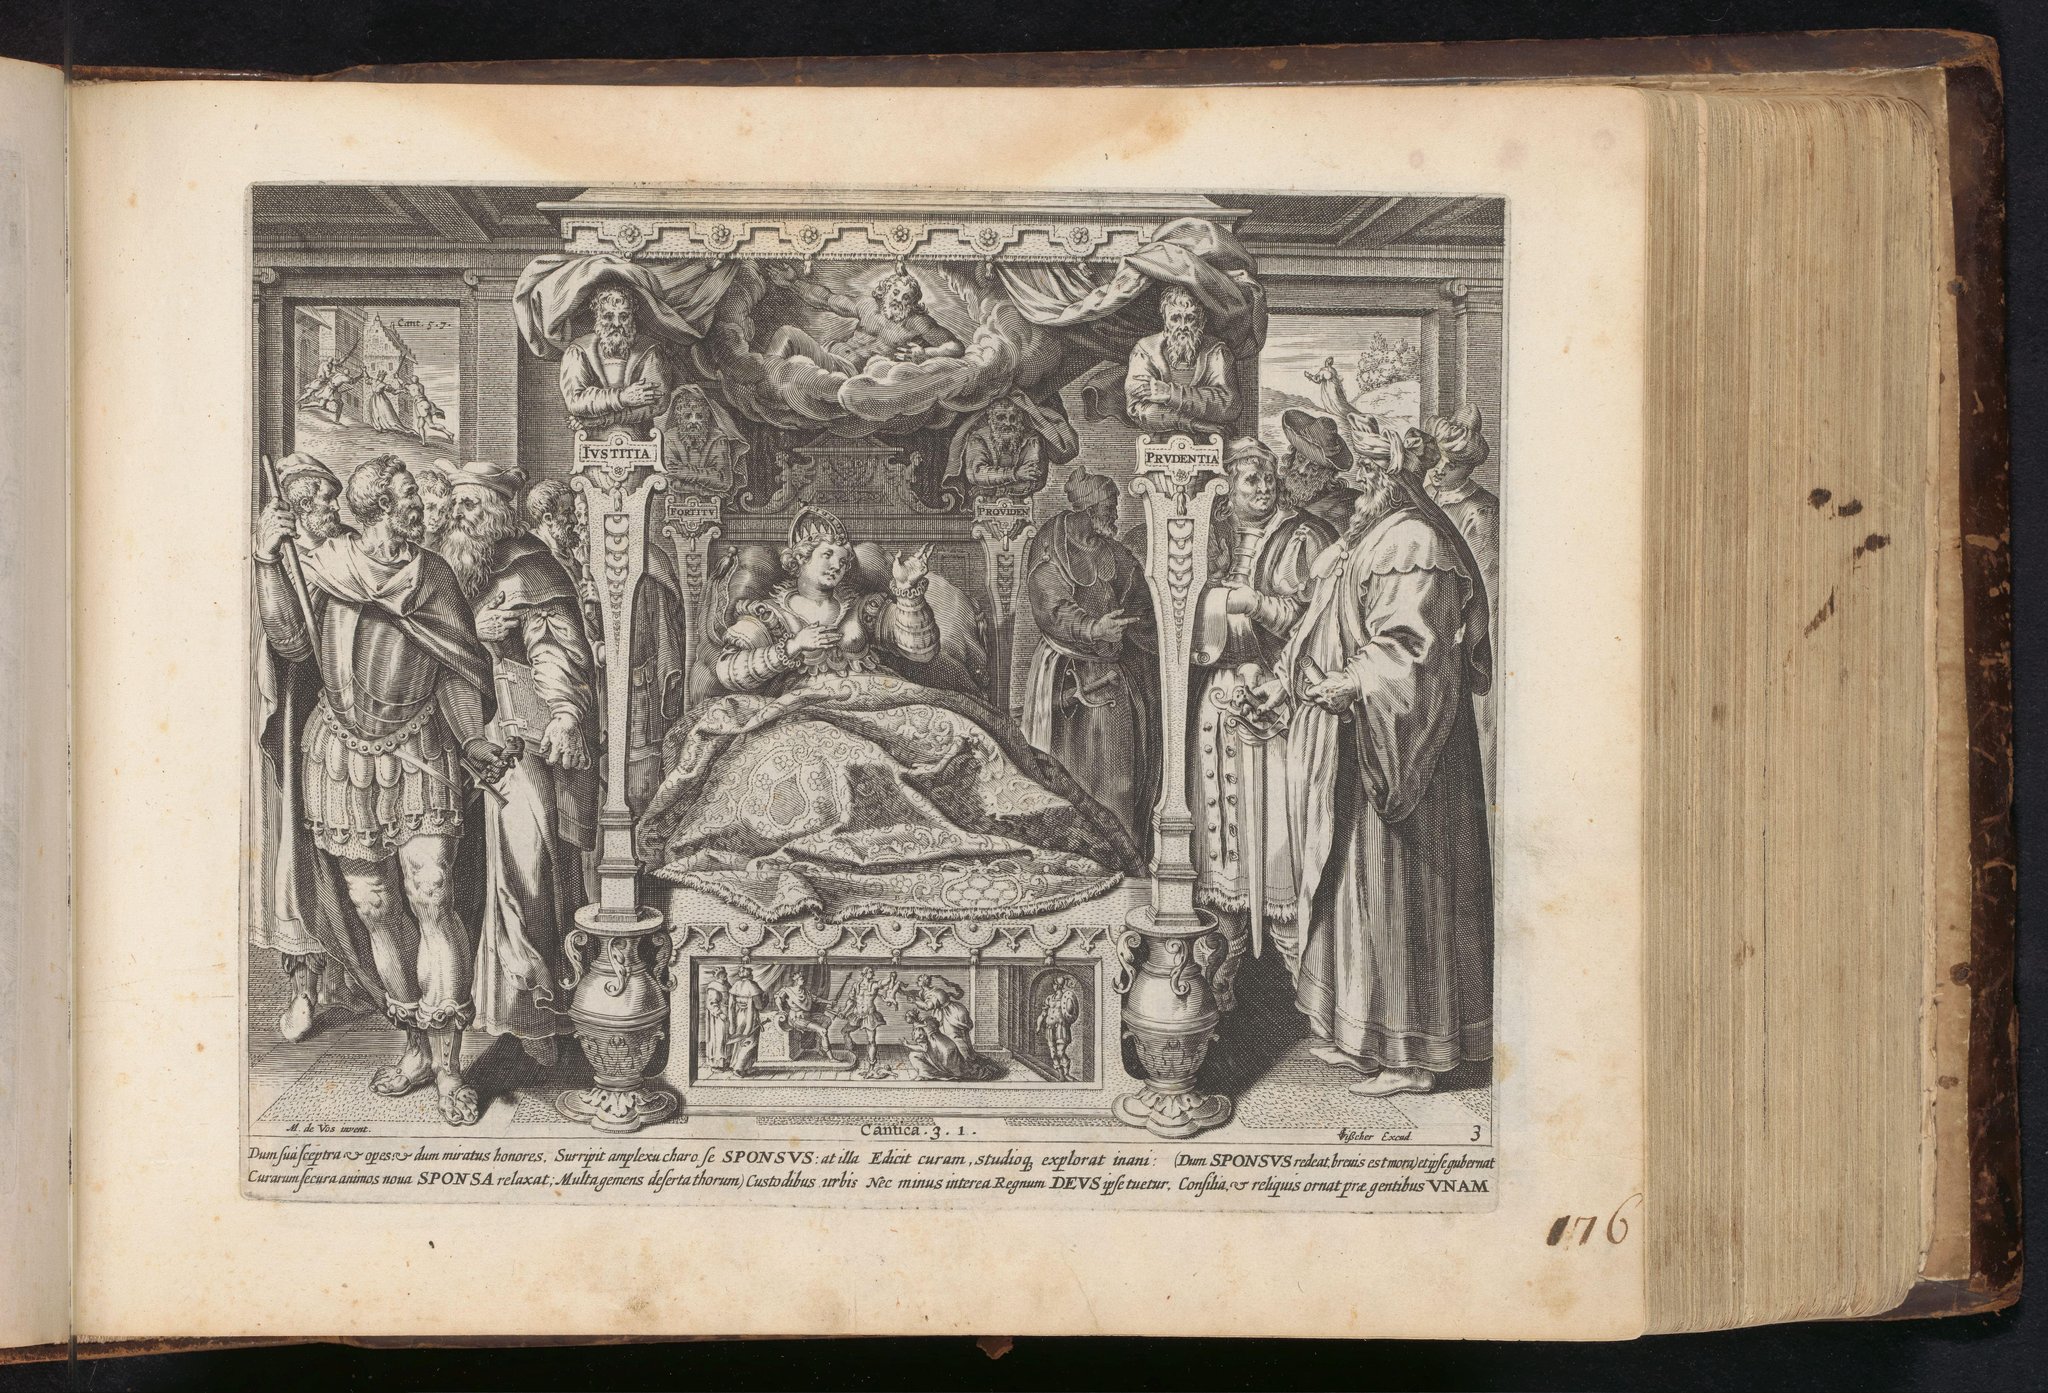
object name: print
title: Canticum Canticorum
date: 1643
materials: paper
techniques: engraving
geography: amsterdam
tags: fortitude, 'fortitudo' ~ one of the four cardinal virtues, 'ecclesia' as bride of christ (the lamb), 'ecclesia sponsa dei', 'sponsus-sponsa', song of solomon, song of songs (with book chapter:verse) (+ christ bearded), the judgement of solomon (1 kings 3:16-28), justice, 'justitia'; 'giustitia divina' (ripa) ~ one of the four cardinal virtues, prudence, 'prudentia'; 'prudenza' (ripa) ~ one of the four cardinal virtues, caryatids ~ architecture, bed with tester, forethought, deliberation; 'previdenza', 'providenza' (ripa), groups of persons from the old testament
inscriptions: number: ‘176’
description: De bruid van Christus (de kerk) in een bed met een baldakijn. Het baldakijn wordt gedragen door de kardinale deugden. Op het voeteneind een voorstelling van het oordeel van Salomo. Boven het hoofd van de bruid Christus in een wolk. Rond het bed figuren uit het Oude Testament. Op de achtergrond door een deuropening is de bruid van Christus te zien die in de stad op zoek is naar haar lief. Onder de voorstelling een verwijzing in het Latijn naar de Bijbeltekst in Hoogl. 3:1. Deze prent maakt deel uit van een album.